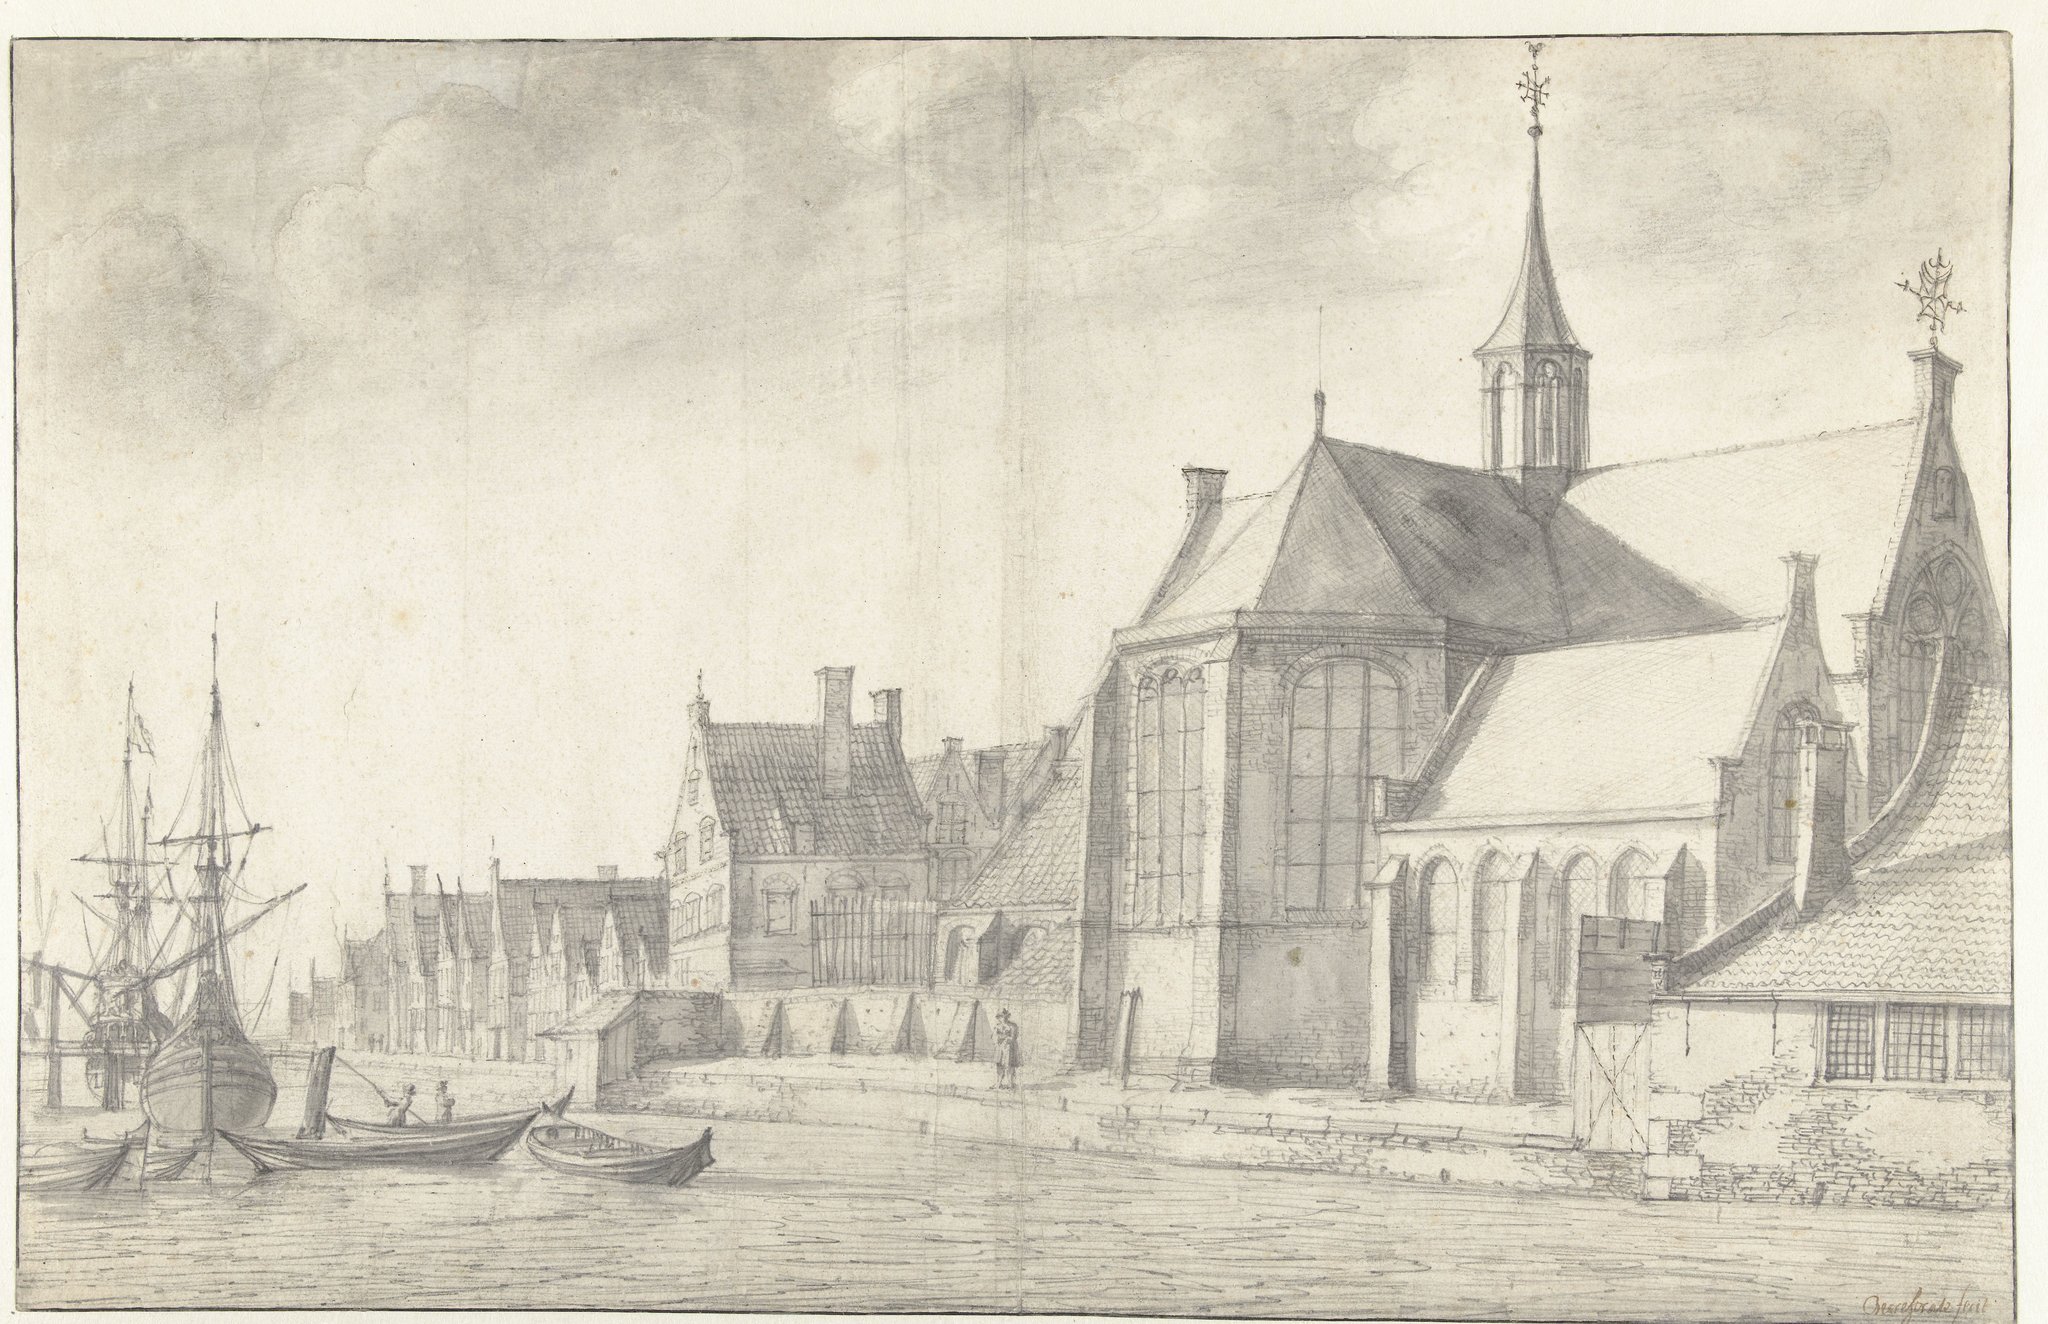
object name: drawing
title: Kerk te Delfshaven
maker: jan abrahamsz. beerstraten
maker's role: draughtsman, painter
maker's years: 1622-1666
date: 1600-1699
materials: graphite, paper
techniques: brush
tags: church (exterior), delfshaven